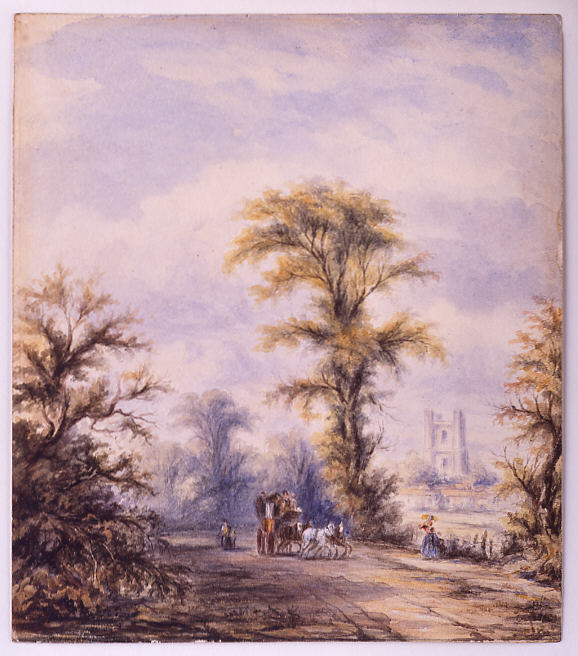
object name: drawing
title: Landscape with a Stagecoach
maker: british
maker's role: artist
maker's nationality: british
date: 1840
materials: graphite, paper, watercolor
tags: roads,landscapes,carriages